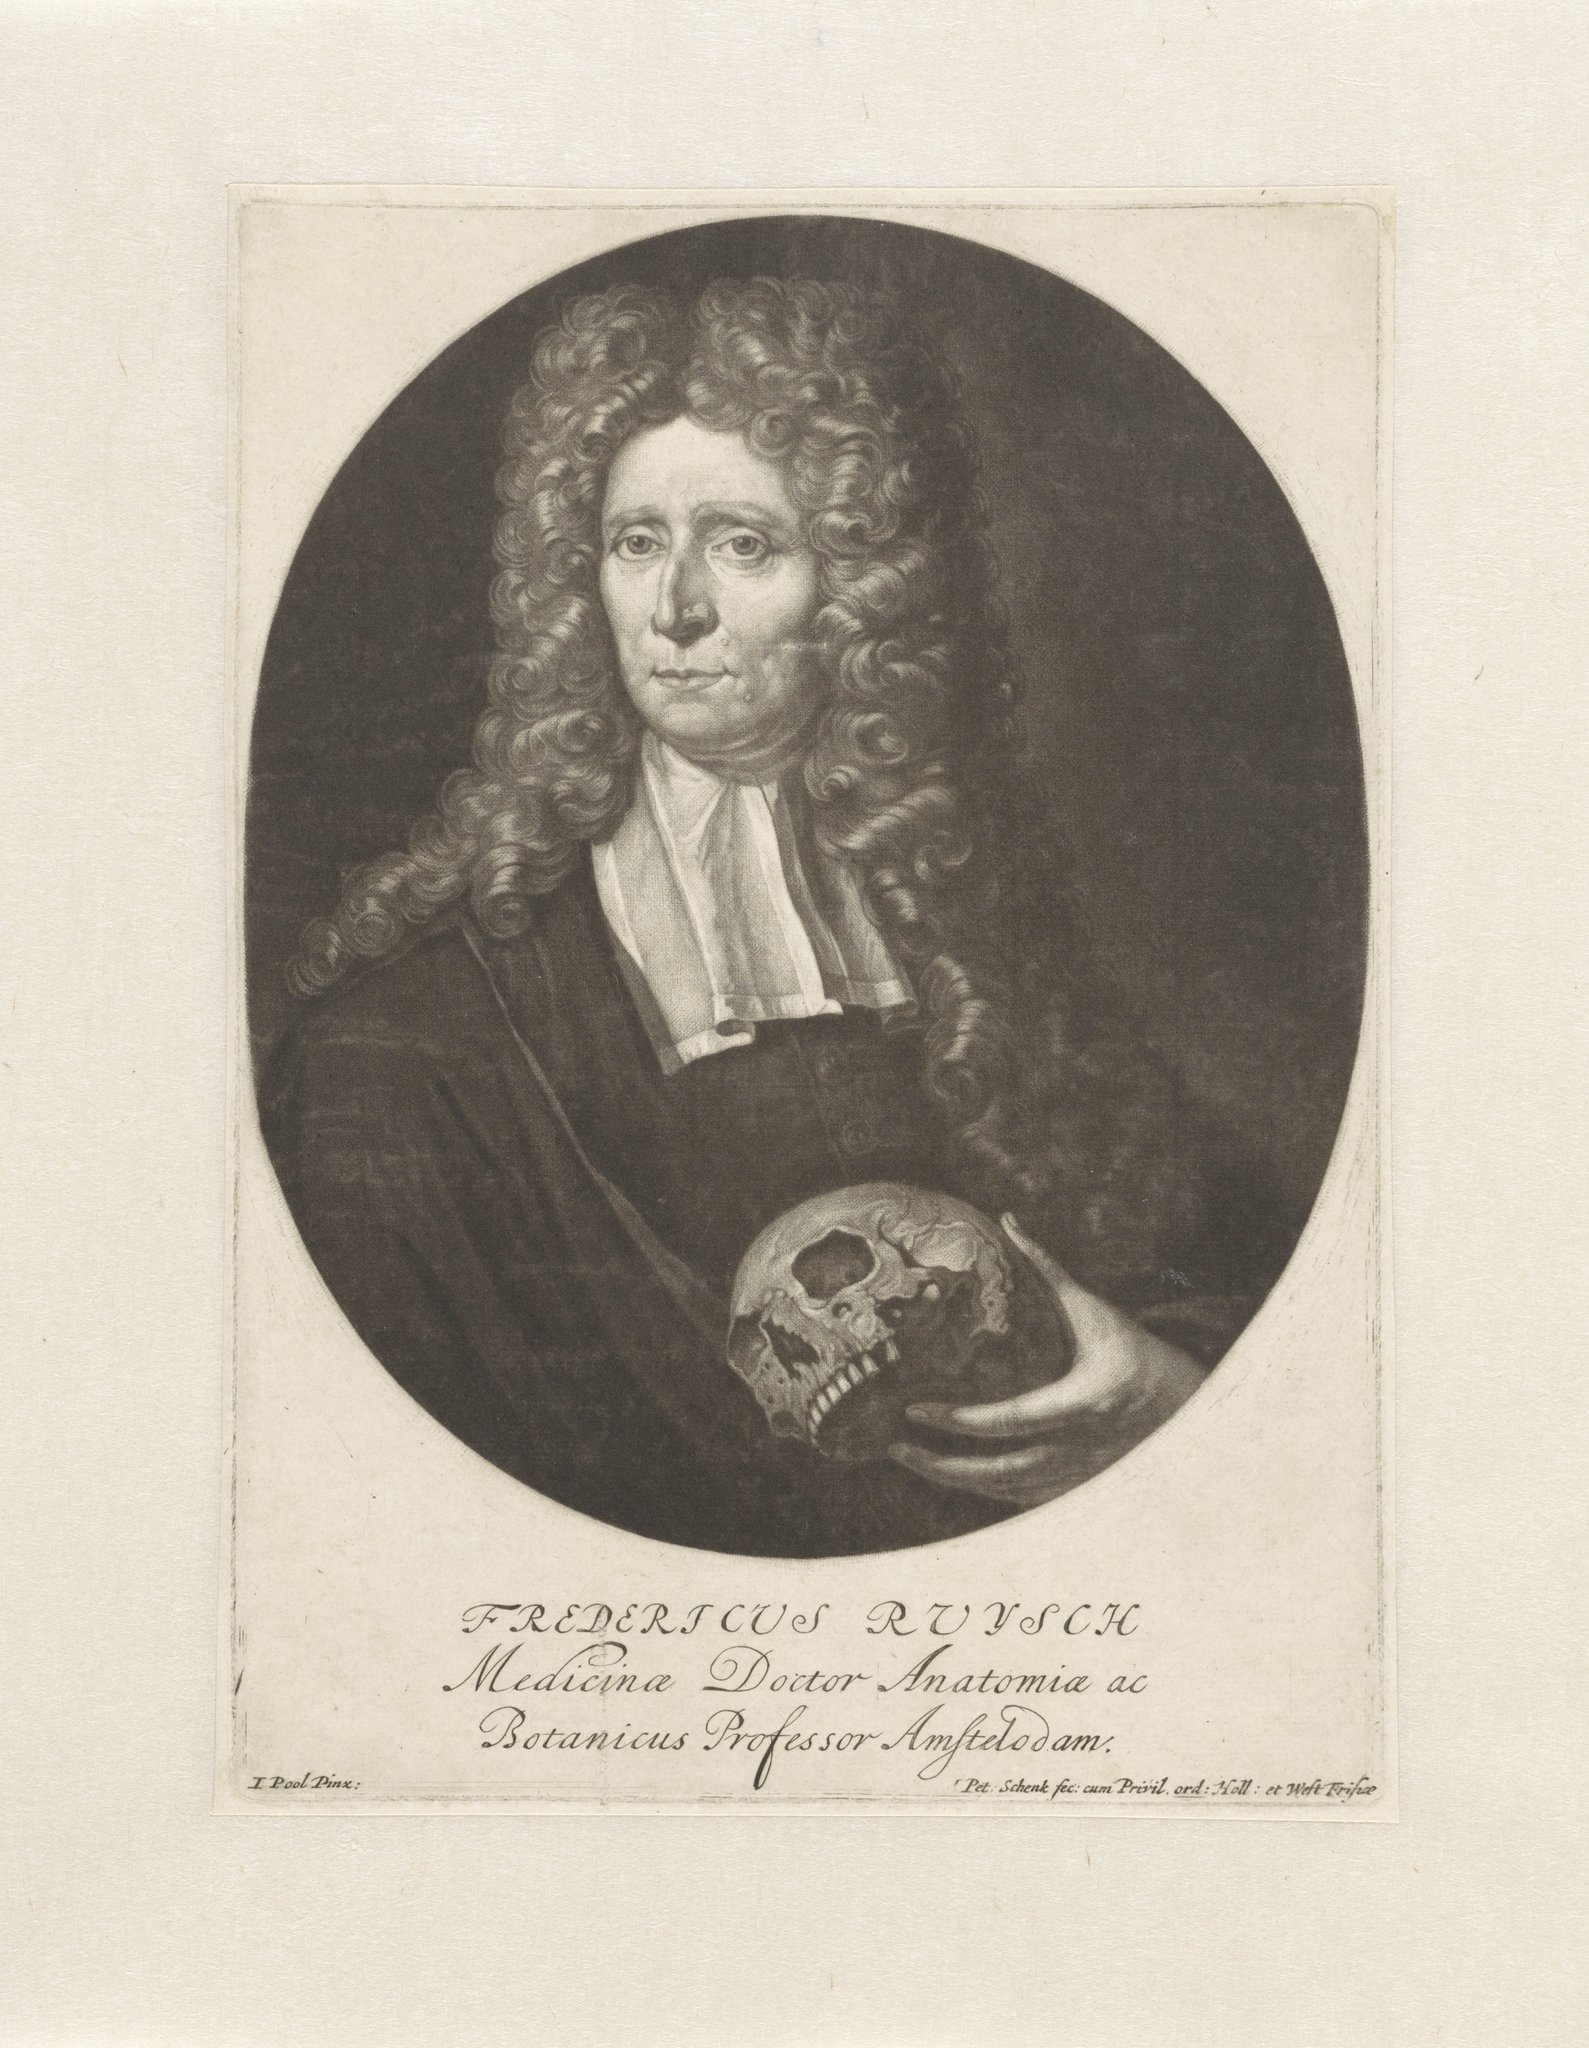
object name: print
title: Portret van de arts en botanicus Frederick Ruysch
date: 1702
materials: paper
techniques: engraving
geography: amsterdam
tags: the hague, amsterdam, frederik ruysch, (human) skull, historical persons, medicine, medical science (+ portrait of scholar, scientist), professor, biology (+ portrait of scholar, scientist)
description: Frederik Ruysch (Den Haag 23 maart, 1638 — 22 februari, 1731): Nederlands anatoom, zoöloog en botanicus. Hij bracht de kunst van het balsemen van lijken op een ongekend hoog plan en werkte als professor in het Sint-Pietergasthuis en de Hortus Botanicus Amsterdam, waar hij studenten ontving. In 1661 trouwde hij met een dochter van Pieter Post, de architect.